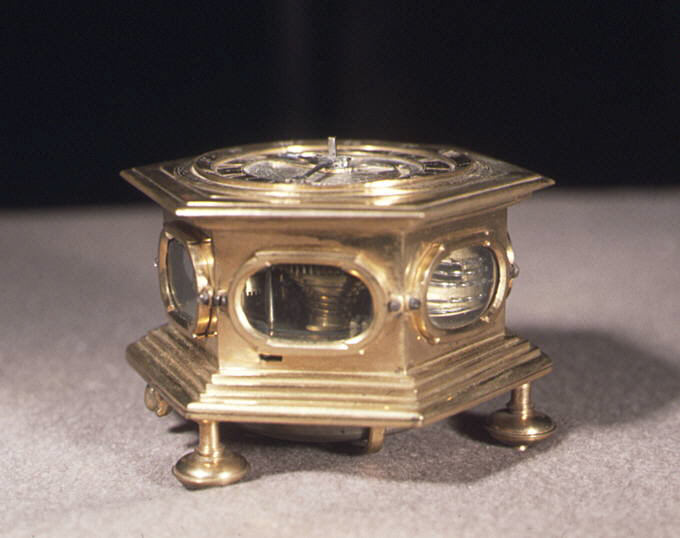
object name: table clock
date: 1601-1633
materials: brass, gilt, glass, silver, steel